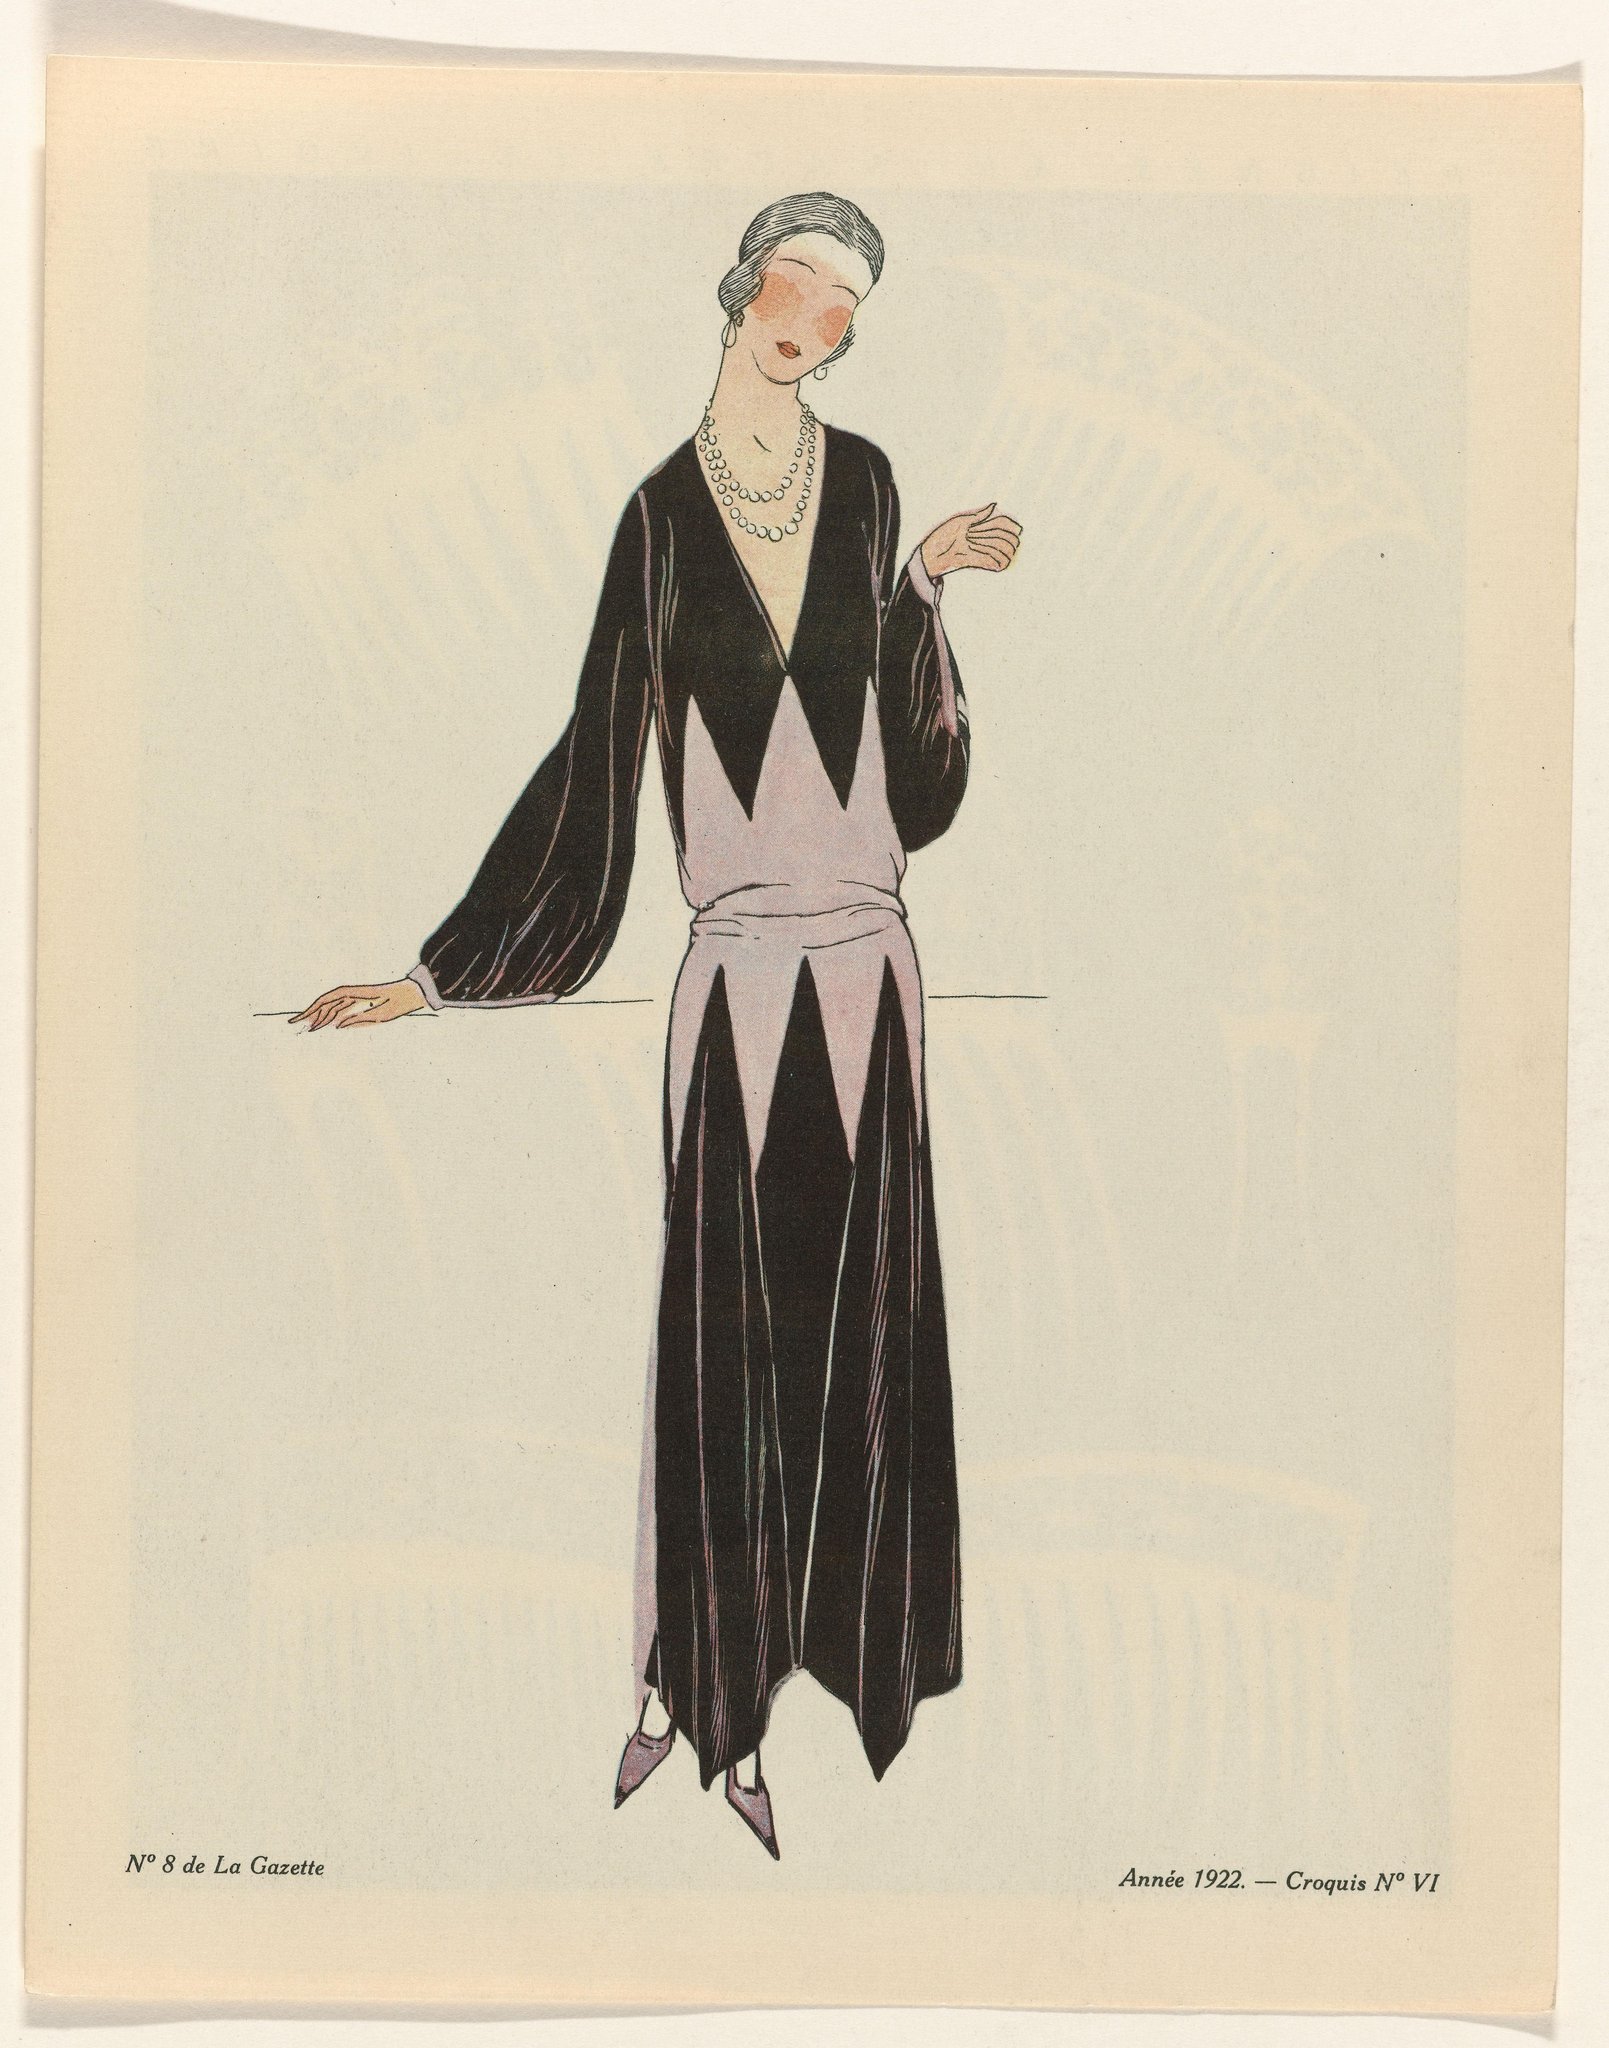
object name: fashion print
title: Gazette du Bon Ton, 1922 - No. 8 : Croquis No VI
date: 1922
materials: paper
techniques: printing, letterpress printing, photochemical processes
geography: london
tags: ear-rings (+ women's clothes), fashion plates, dress, gown (+ women's clothes), necklace (+ women's clothes)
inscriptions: date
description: Japon met een groot zig-zag patroon en wijde mouwen. Croquis No VI uit Gazette du Bon Ton 1922, No. 8. Uitleg over de kleding op pagina "Description et explication des planches hors-texte et pages de croquis."